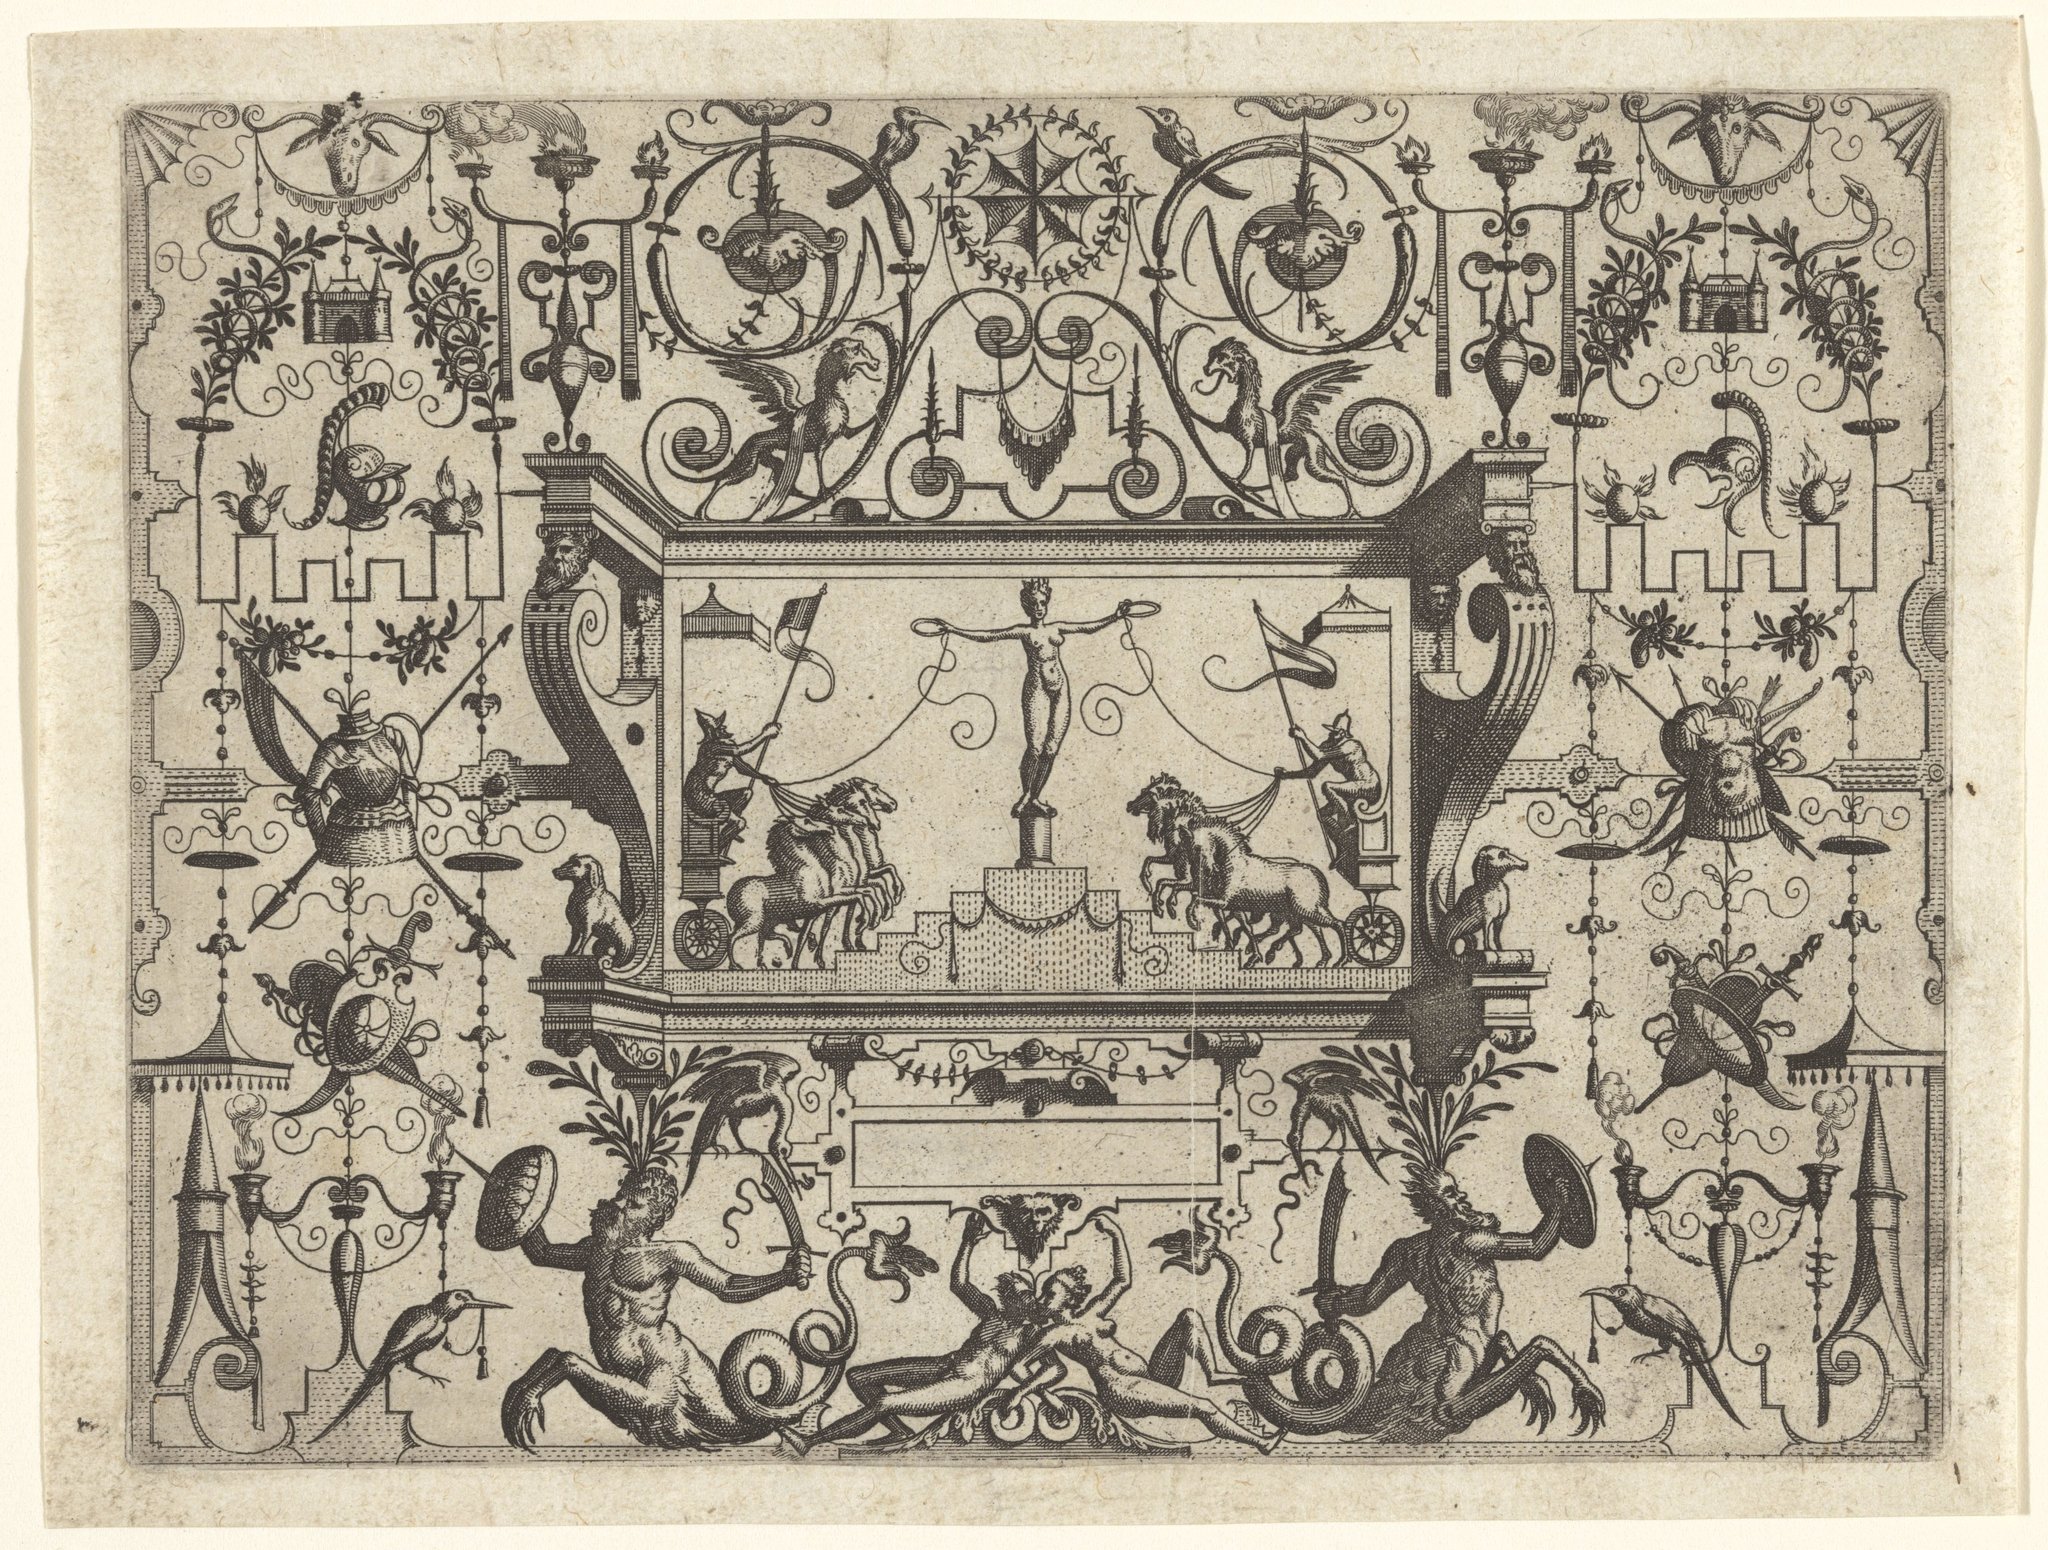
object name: ornament print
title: Rechthoekige cartouche met een vrouw op een voetstuk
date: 1565-1571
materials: paper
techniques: etching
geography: netherlands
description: De vrouw staat tussen twee vierspannen die zij elk met een zegekrans bekroont. Middenonder ligt een paar tussen twee tritons met een schild en een houwer. Uit serie van titelblad + 16 bladen met cartouches of architectuurfantasieën met een voorstelling in een omlijsting van grotesken met fabelwezens, dieren, guirlandes, trofeeën en mascarons.